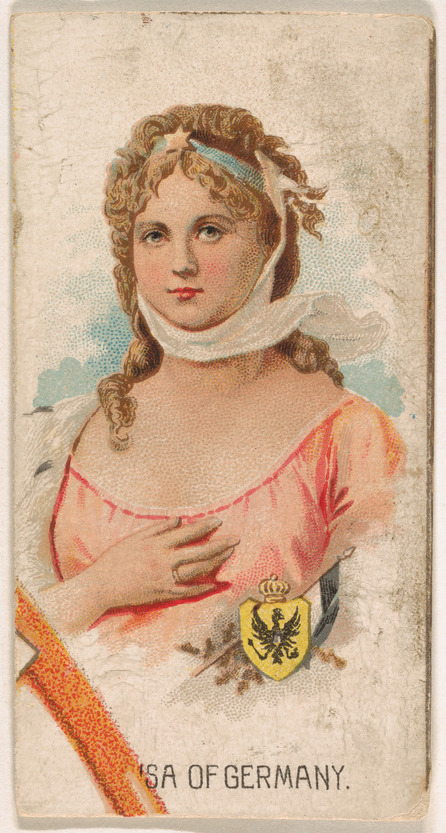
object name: print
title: Example of display card, Louisa of Germany, from Leaders series (N222) issued by Kinney Bros.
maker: kinney brothers tobacco company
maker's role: publisher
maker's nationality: american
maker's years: 1869-2011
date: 1888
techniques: color lithograph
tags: women